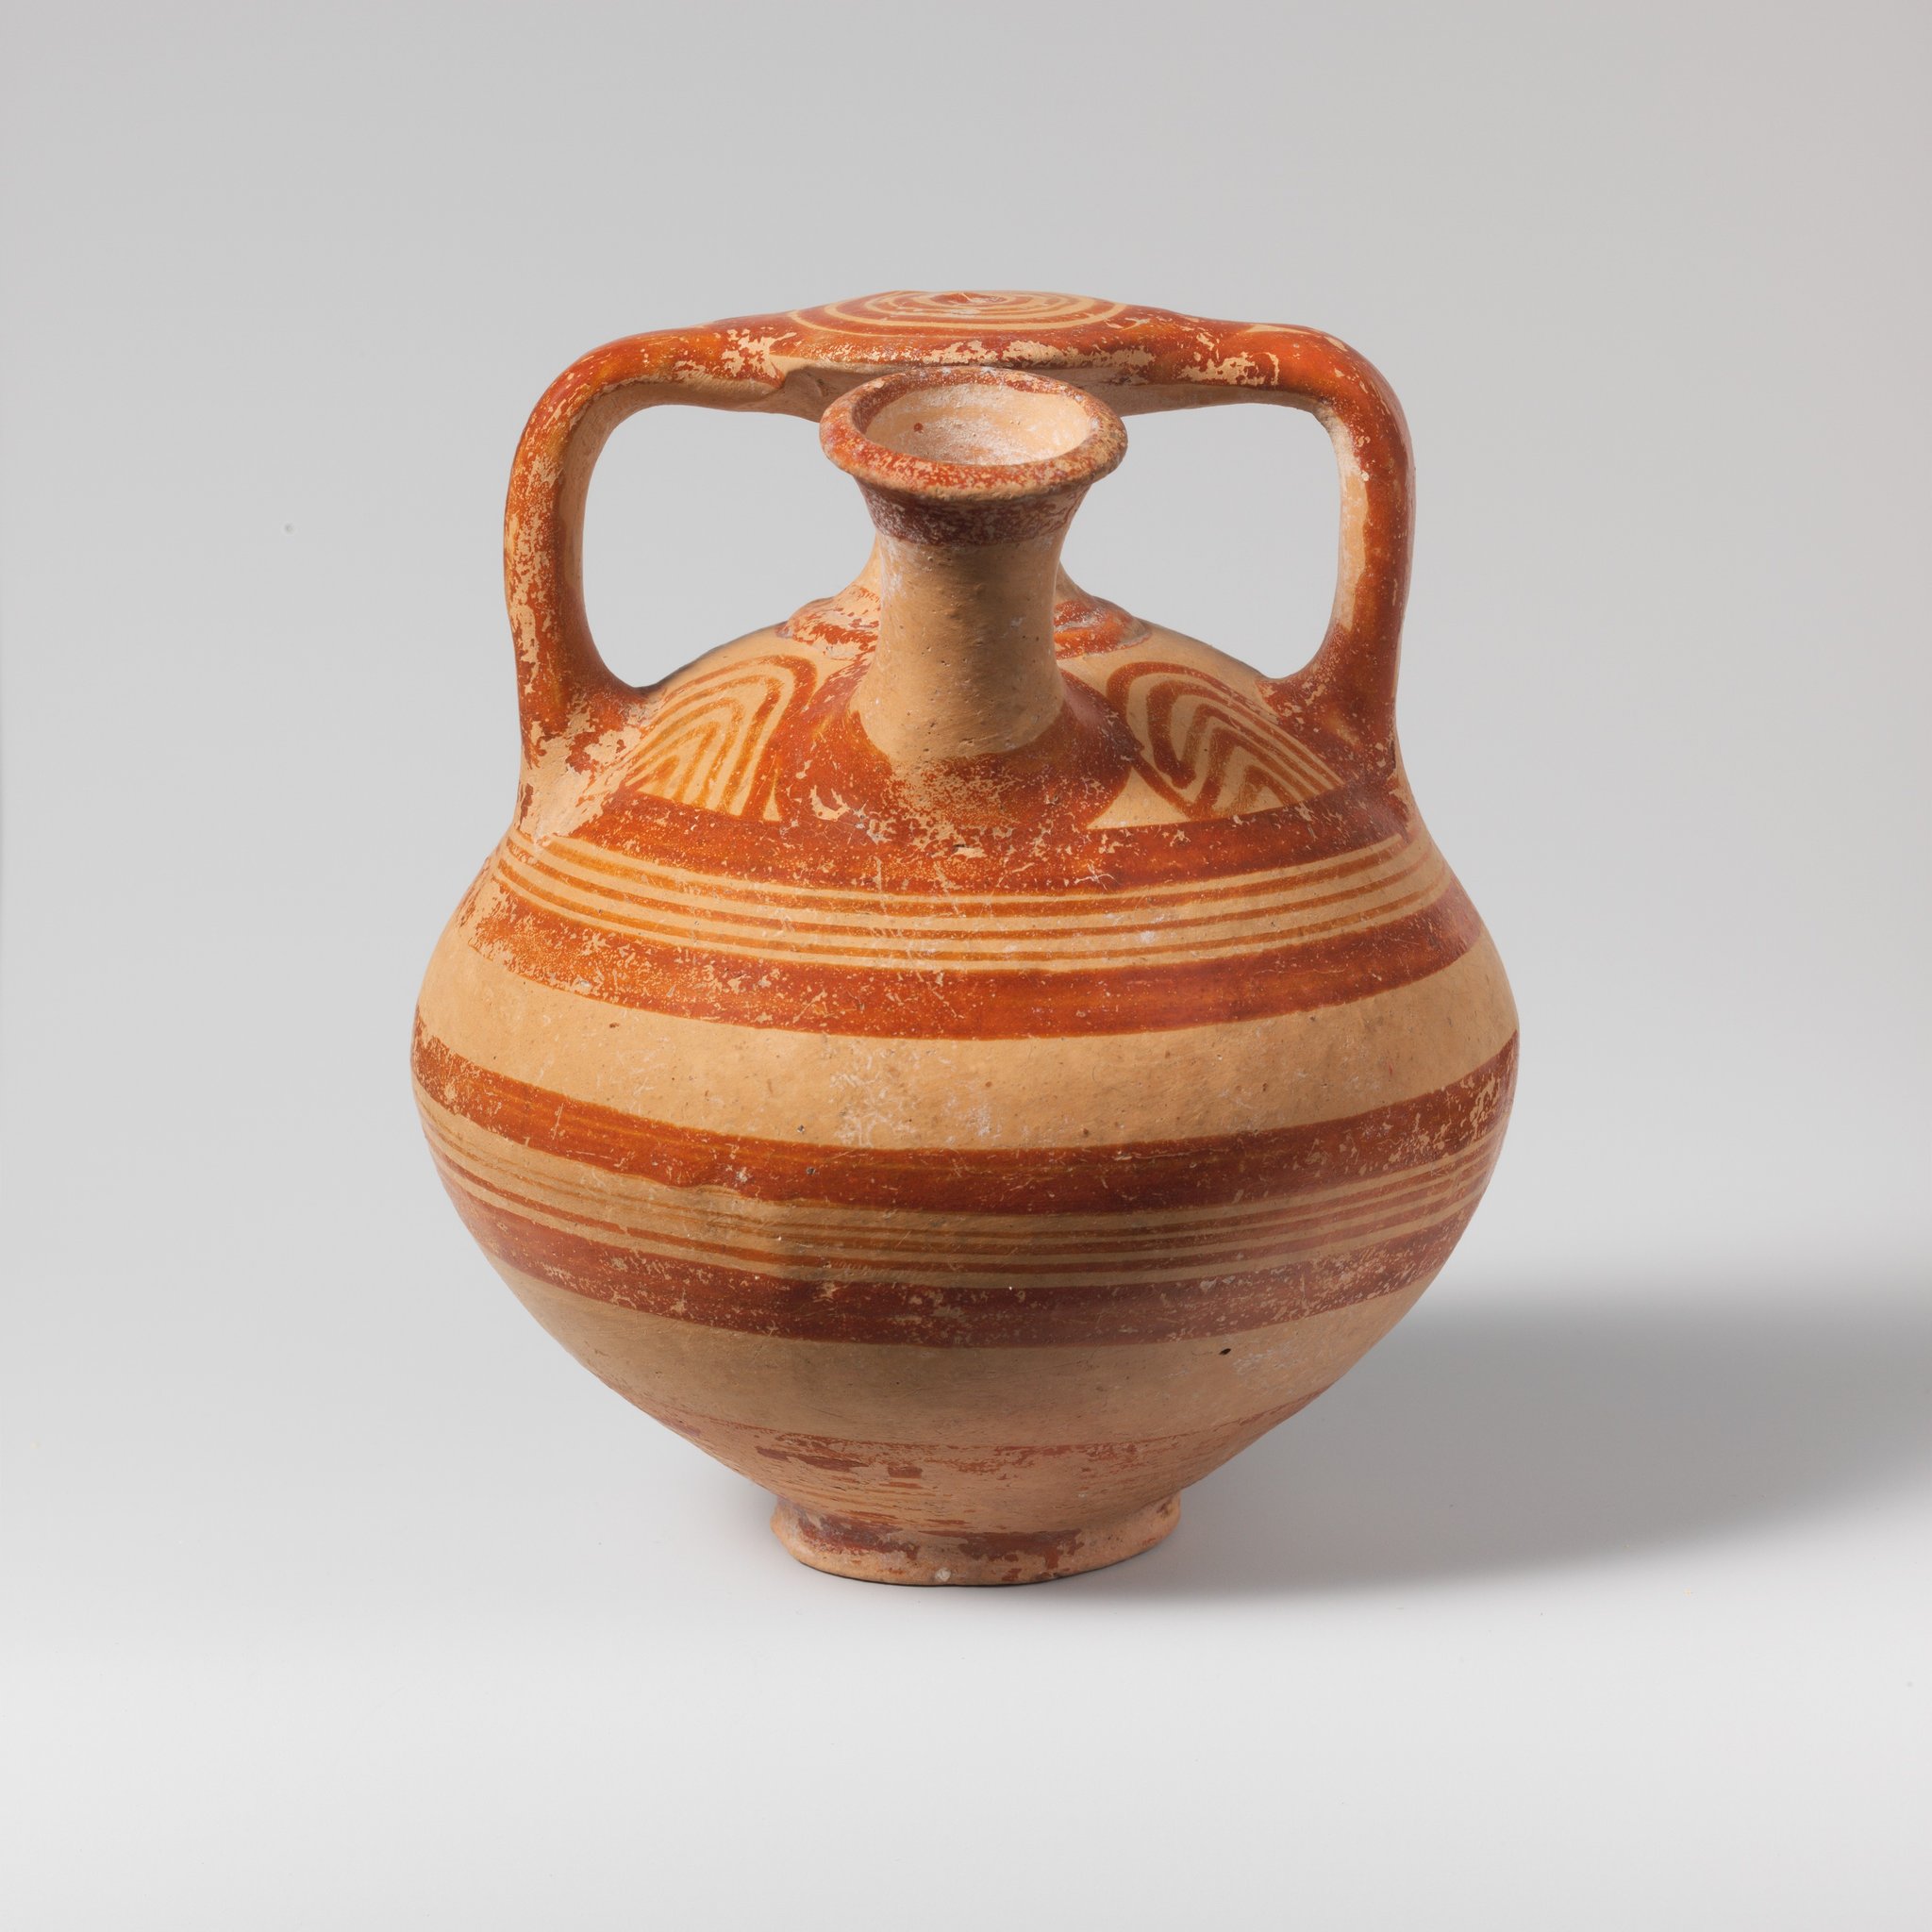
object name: stirrup jar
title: Terracotta stirrup jar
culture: mycenaean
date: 1400-1050 BCE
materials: terracotta